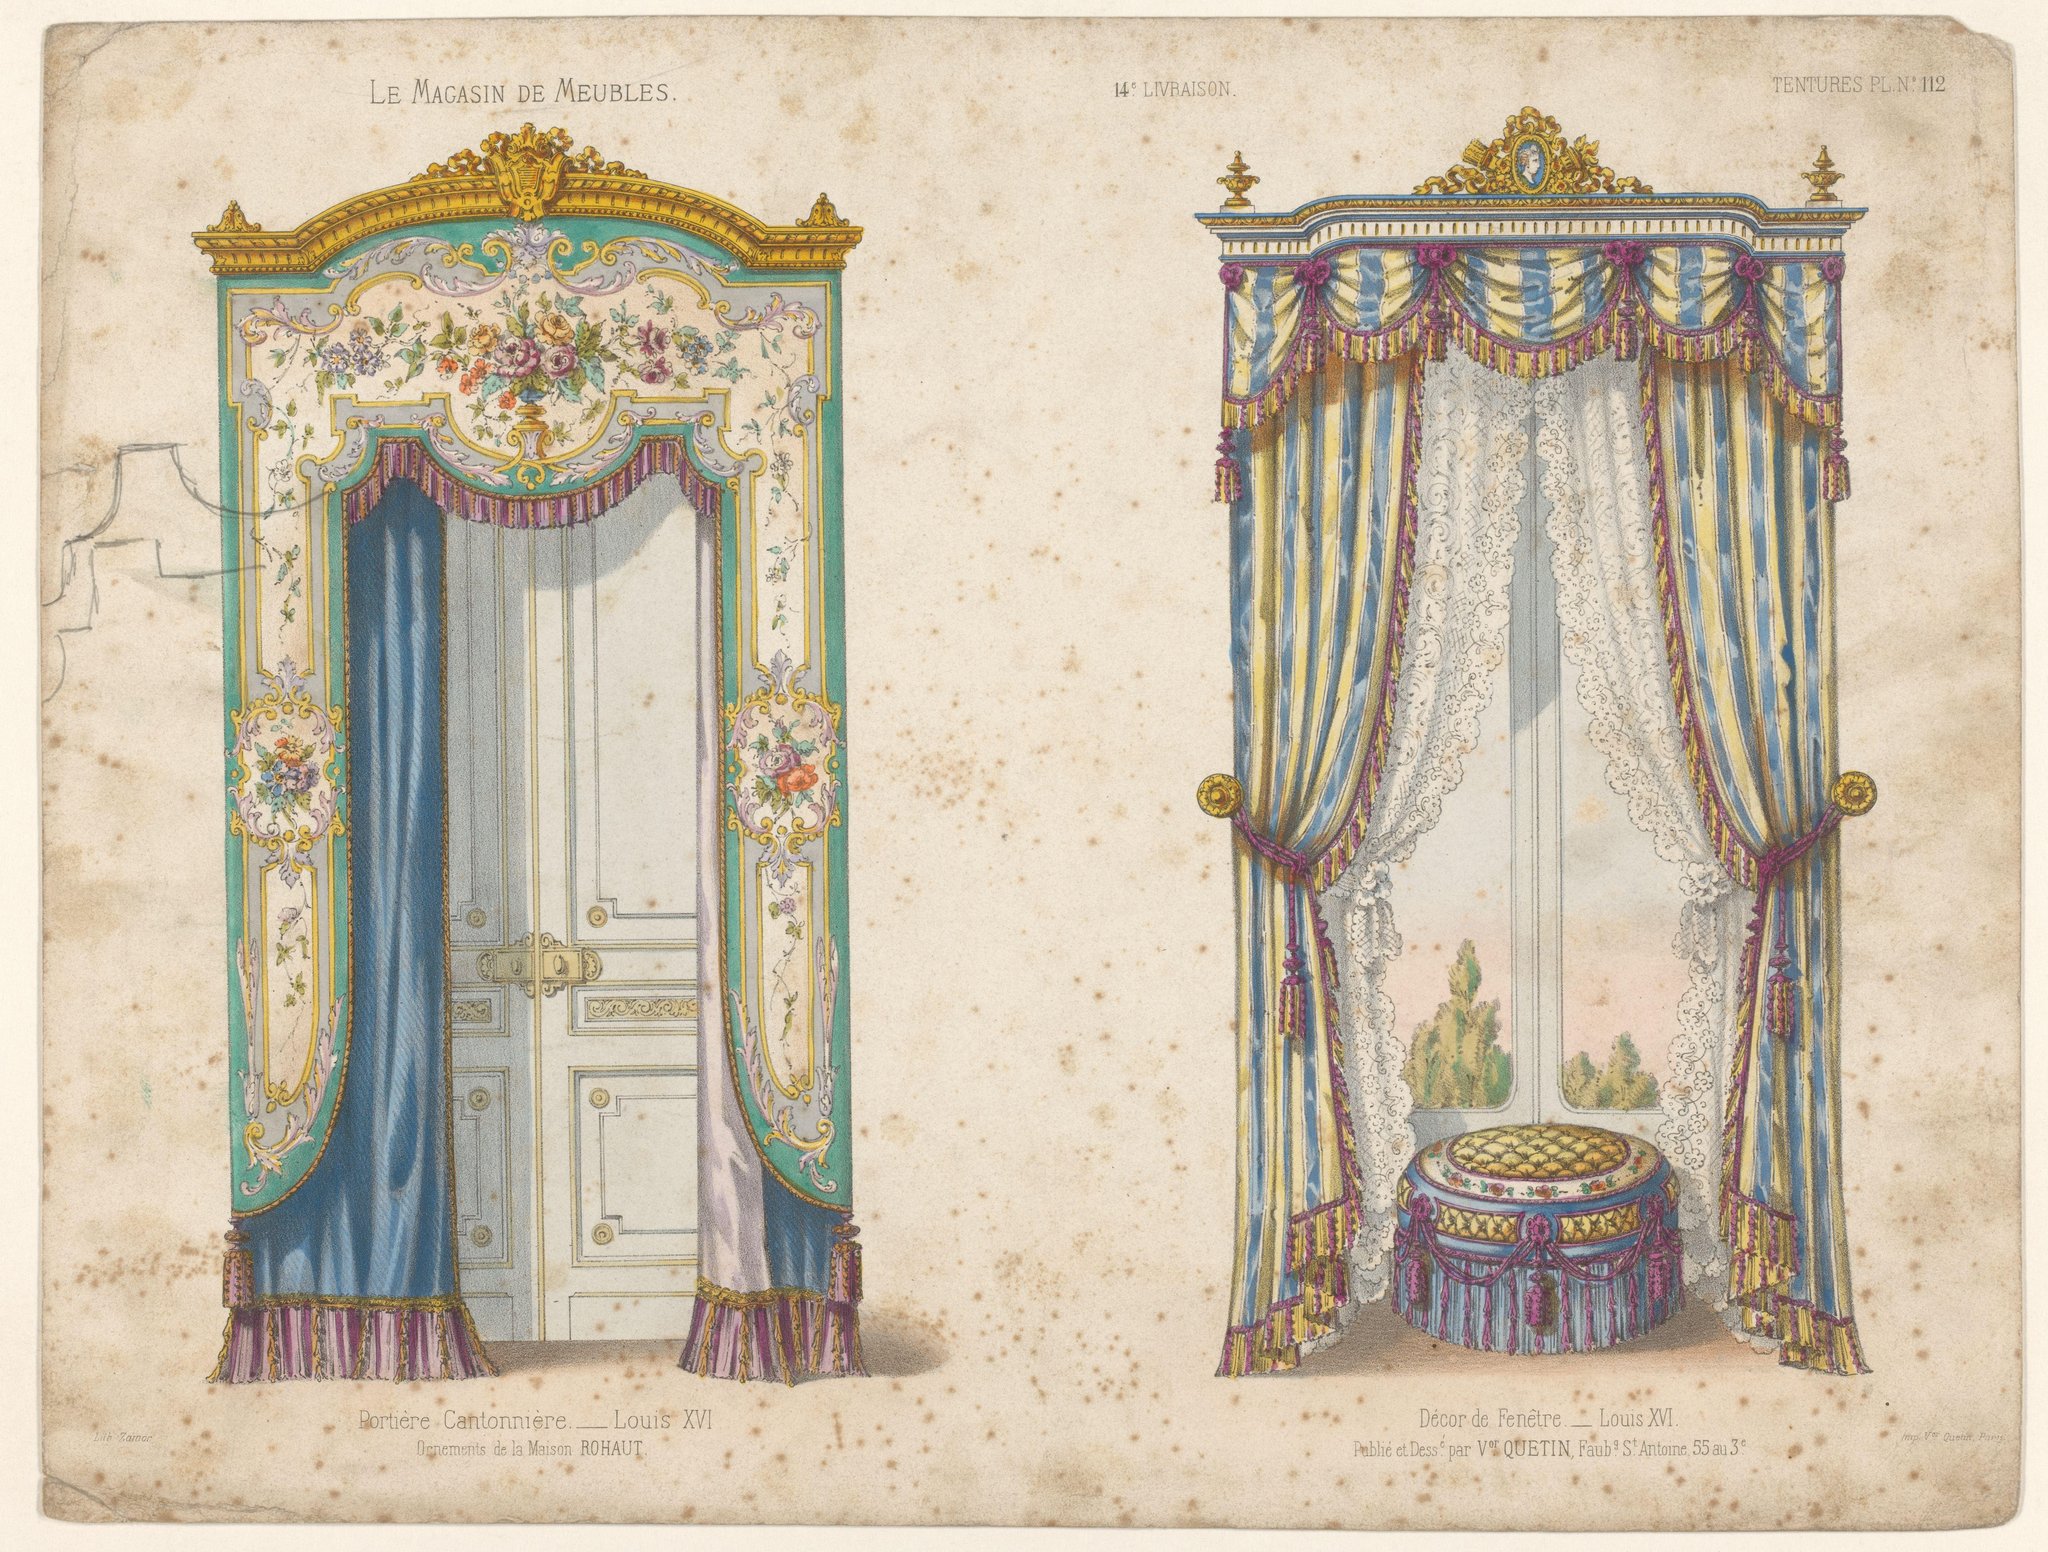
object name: print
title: Portière Cantonnière. Louis XVI / Décor de Fenêtre. Louis XVI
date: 1832-1877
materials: paper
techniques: hand coloring, lithograph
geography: paris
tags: window, door, hangings and drapery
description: Een deur en venster met gedrapeerde gordijnen, beiden in de Lodewijk XVI-stijl. Voor het venster staat een poef. Prent uit 14e Livraison.